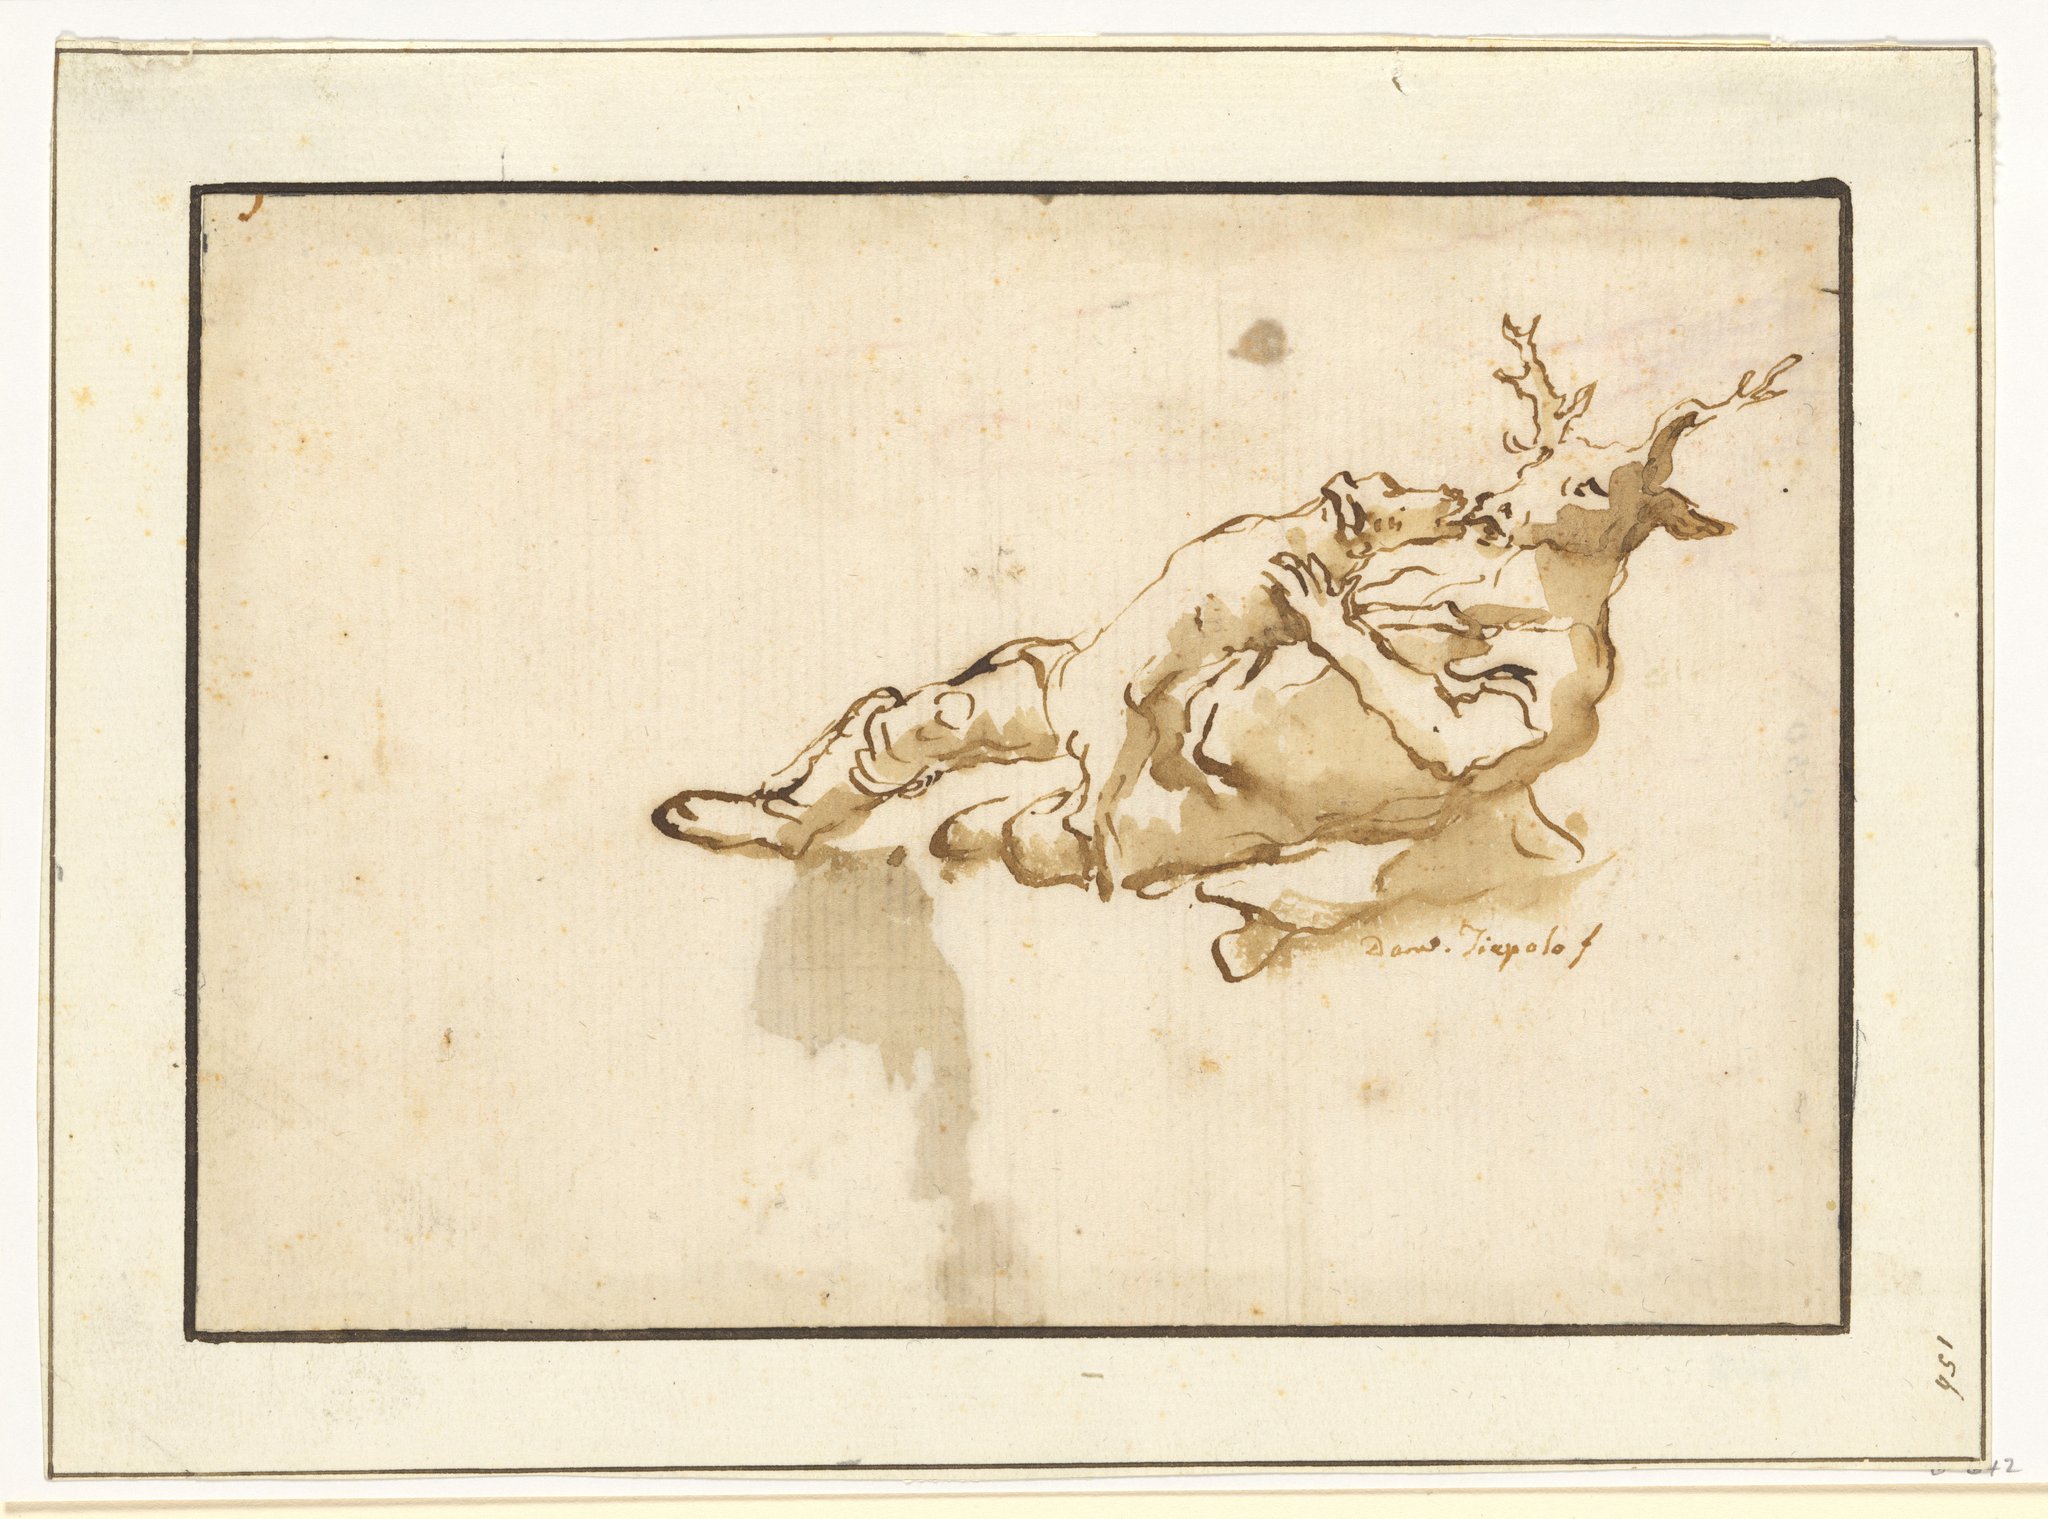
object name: drawing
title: Actaeon, Changed into a Stag, Attacked by One of His Own Hounds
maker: giovanni domenico tiepolo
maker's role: artist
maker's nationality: italian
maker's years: 1727-1804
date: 1767-1800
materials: ink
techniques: pen, wash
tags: actaeon,deer,dogs